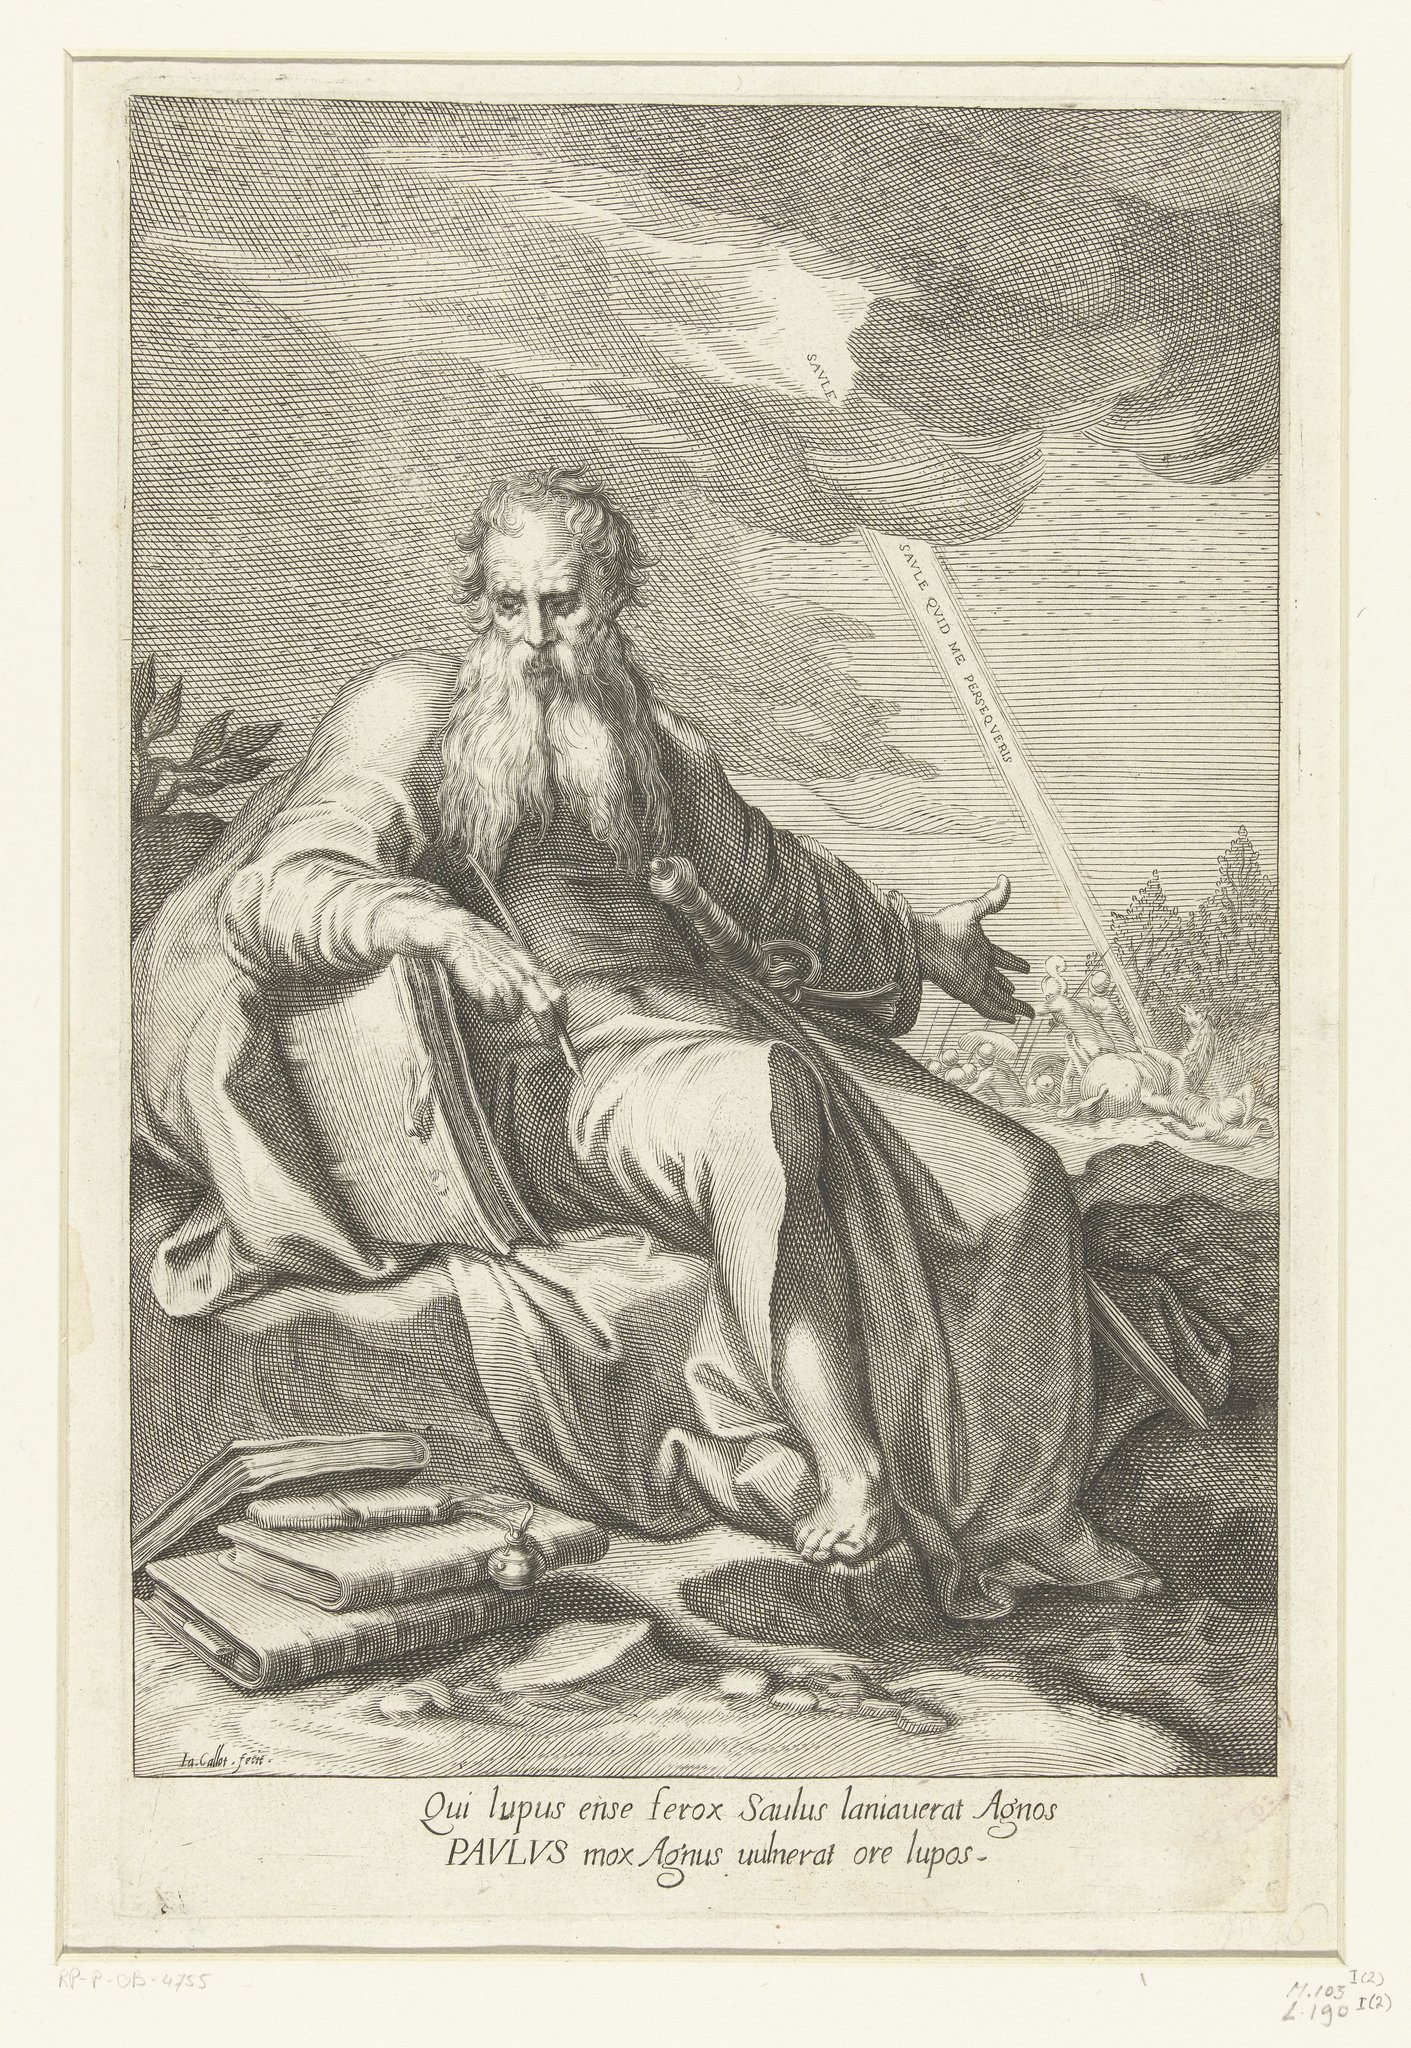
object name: print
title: Heilige Paulus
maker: jacques callot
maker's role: draughtsman, print maker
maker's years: 1592-1635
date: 1611-1622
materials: paper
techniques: engraving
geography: florence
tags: on the way to damascus christ appears to saul, who falls from his horse and is blinded by the light, the apostle paul of tarsus; possible attributes: book, scroll, sword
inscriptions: collector's mark: Lugt 240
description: De Heilige Paulus zit op een rots, omringd door boeken. Op de achtergrond is het verhaal van zijn bekering te zien: hoe hij onderweg naar Damascus getroffen door een groot licht en een stem uit de hemel van zijn paard viel. onder de voorstelling een onderschrift in Latijn.